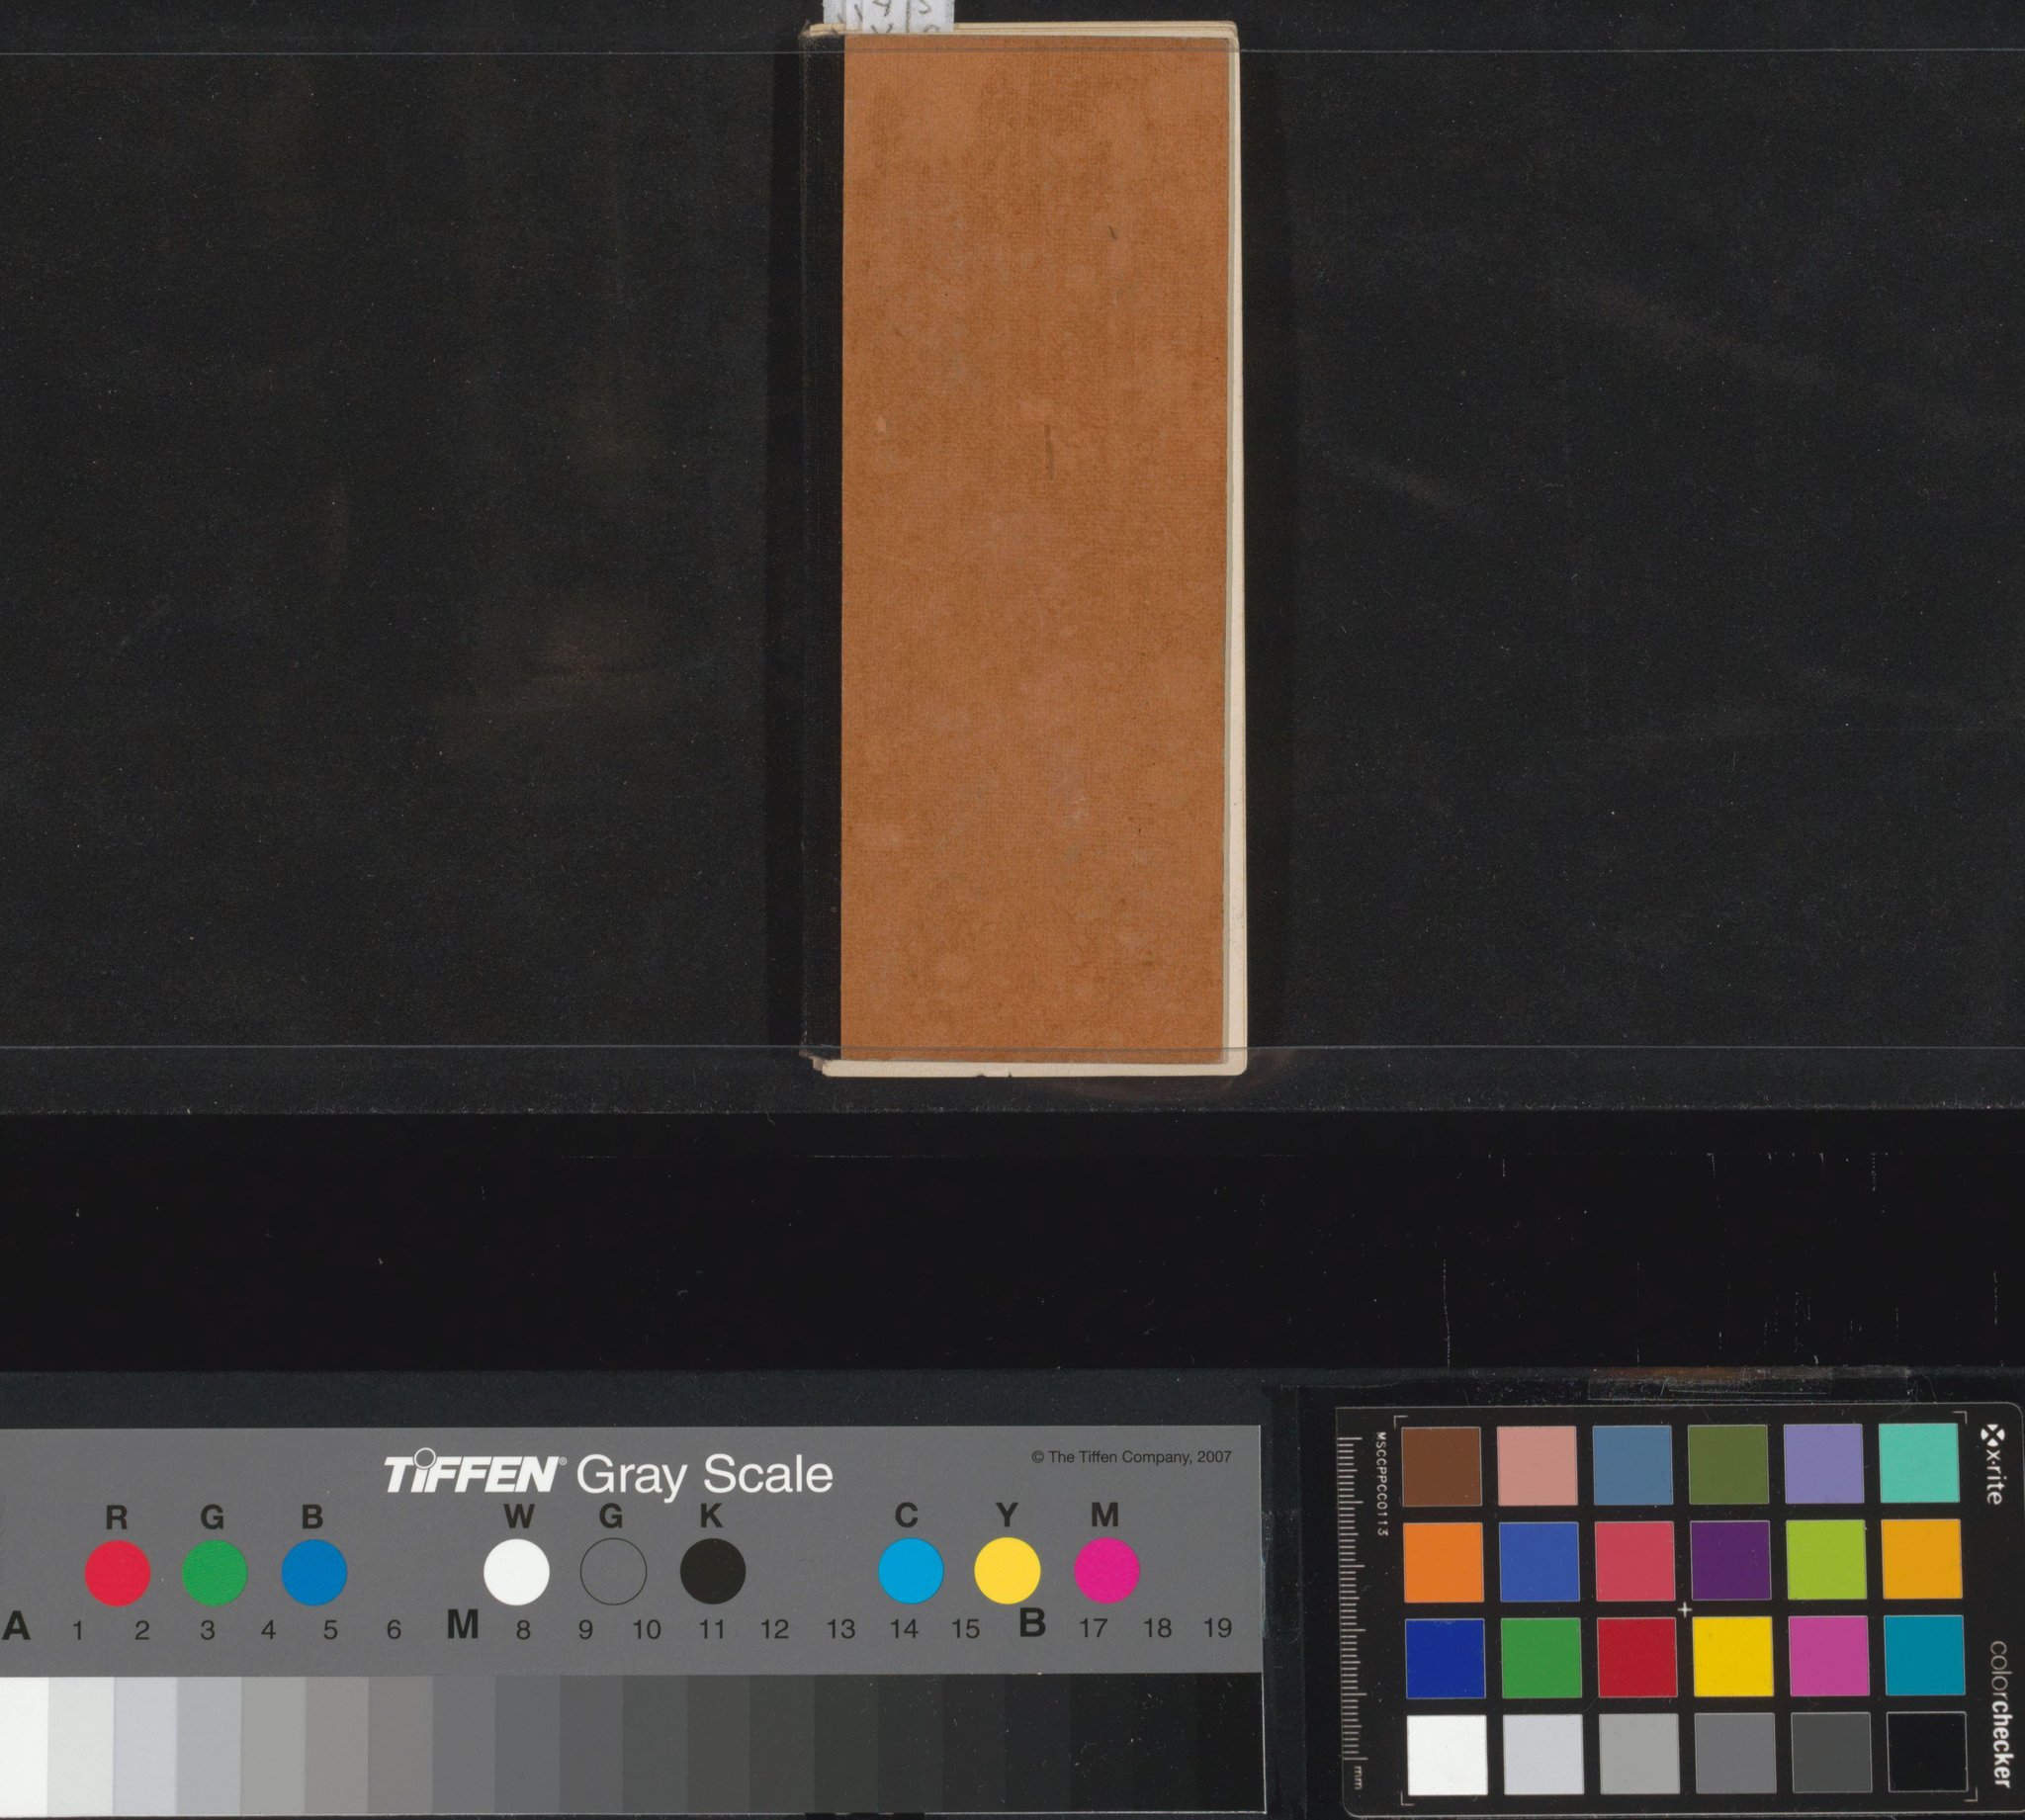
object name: sketchbook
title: Schetsboek met 42 bladen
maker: gerrit willem dijsselhof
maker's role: designer, draughtsman, print maker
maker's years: 1866-1924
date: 1901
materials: cardboard, chalk, linen, paper, pencil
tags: ornaments ~ art, calendar, almanac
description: De volgende bladen uit het schetsboek zijn blanco: 5(V) t/m 11(V), 12(R), 15(R), 16(R), 18(R) t/m 21(R), 22(V) t/m 24(V), 27(V), 28 t/m 32 en 33(R) t/m 38(R).